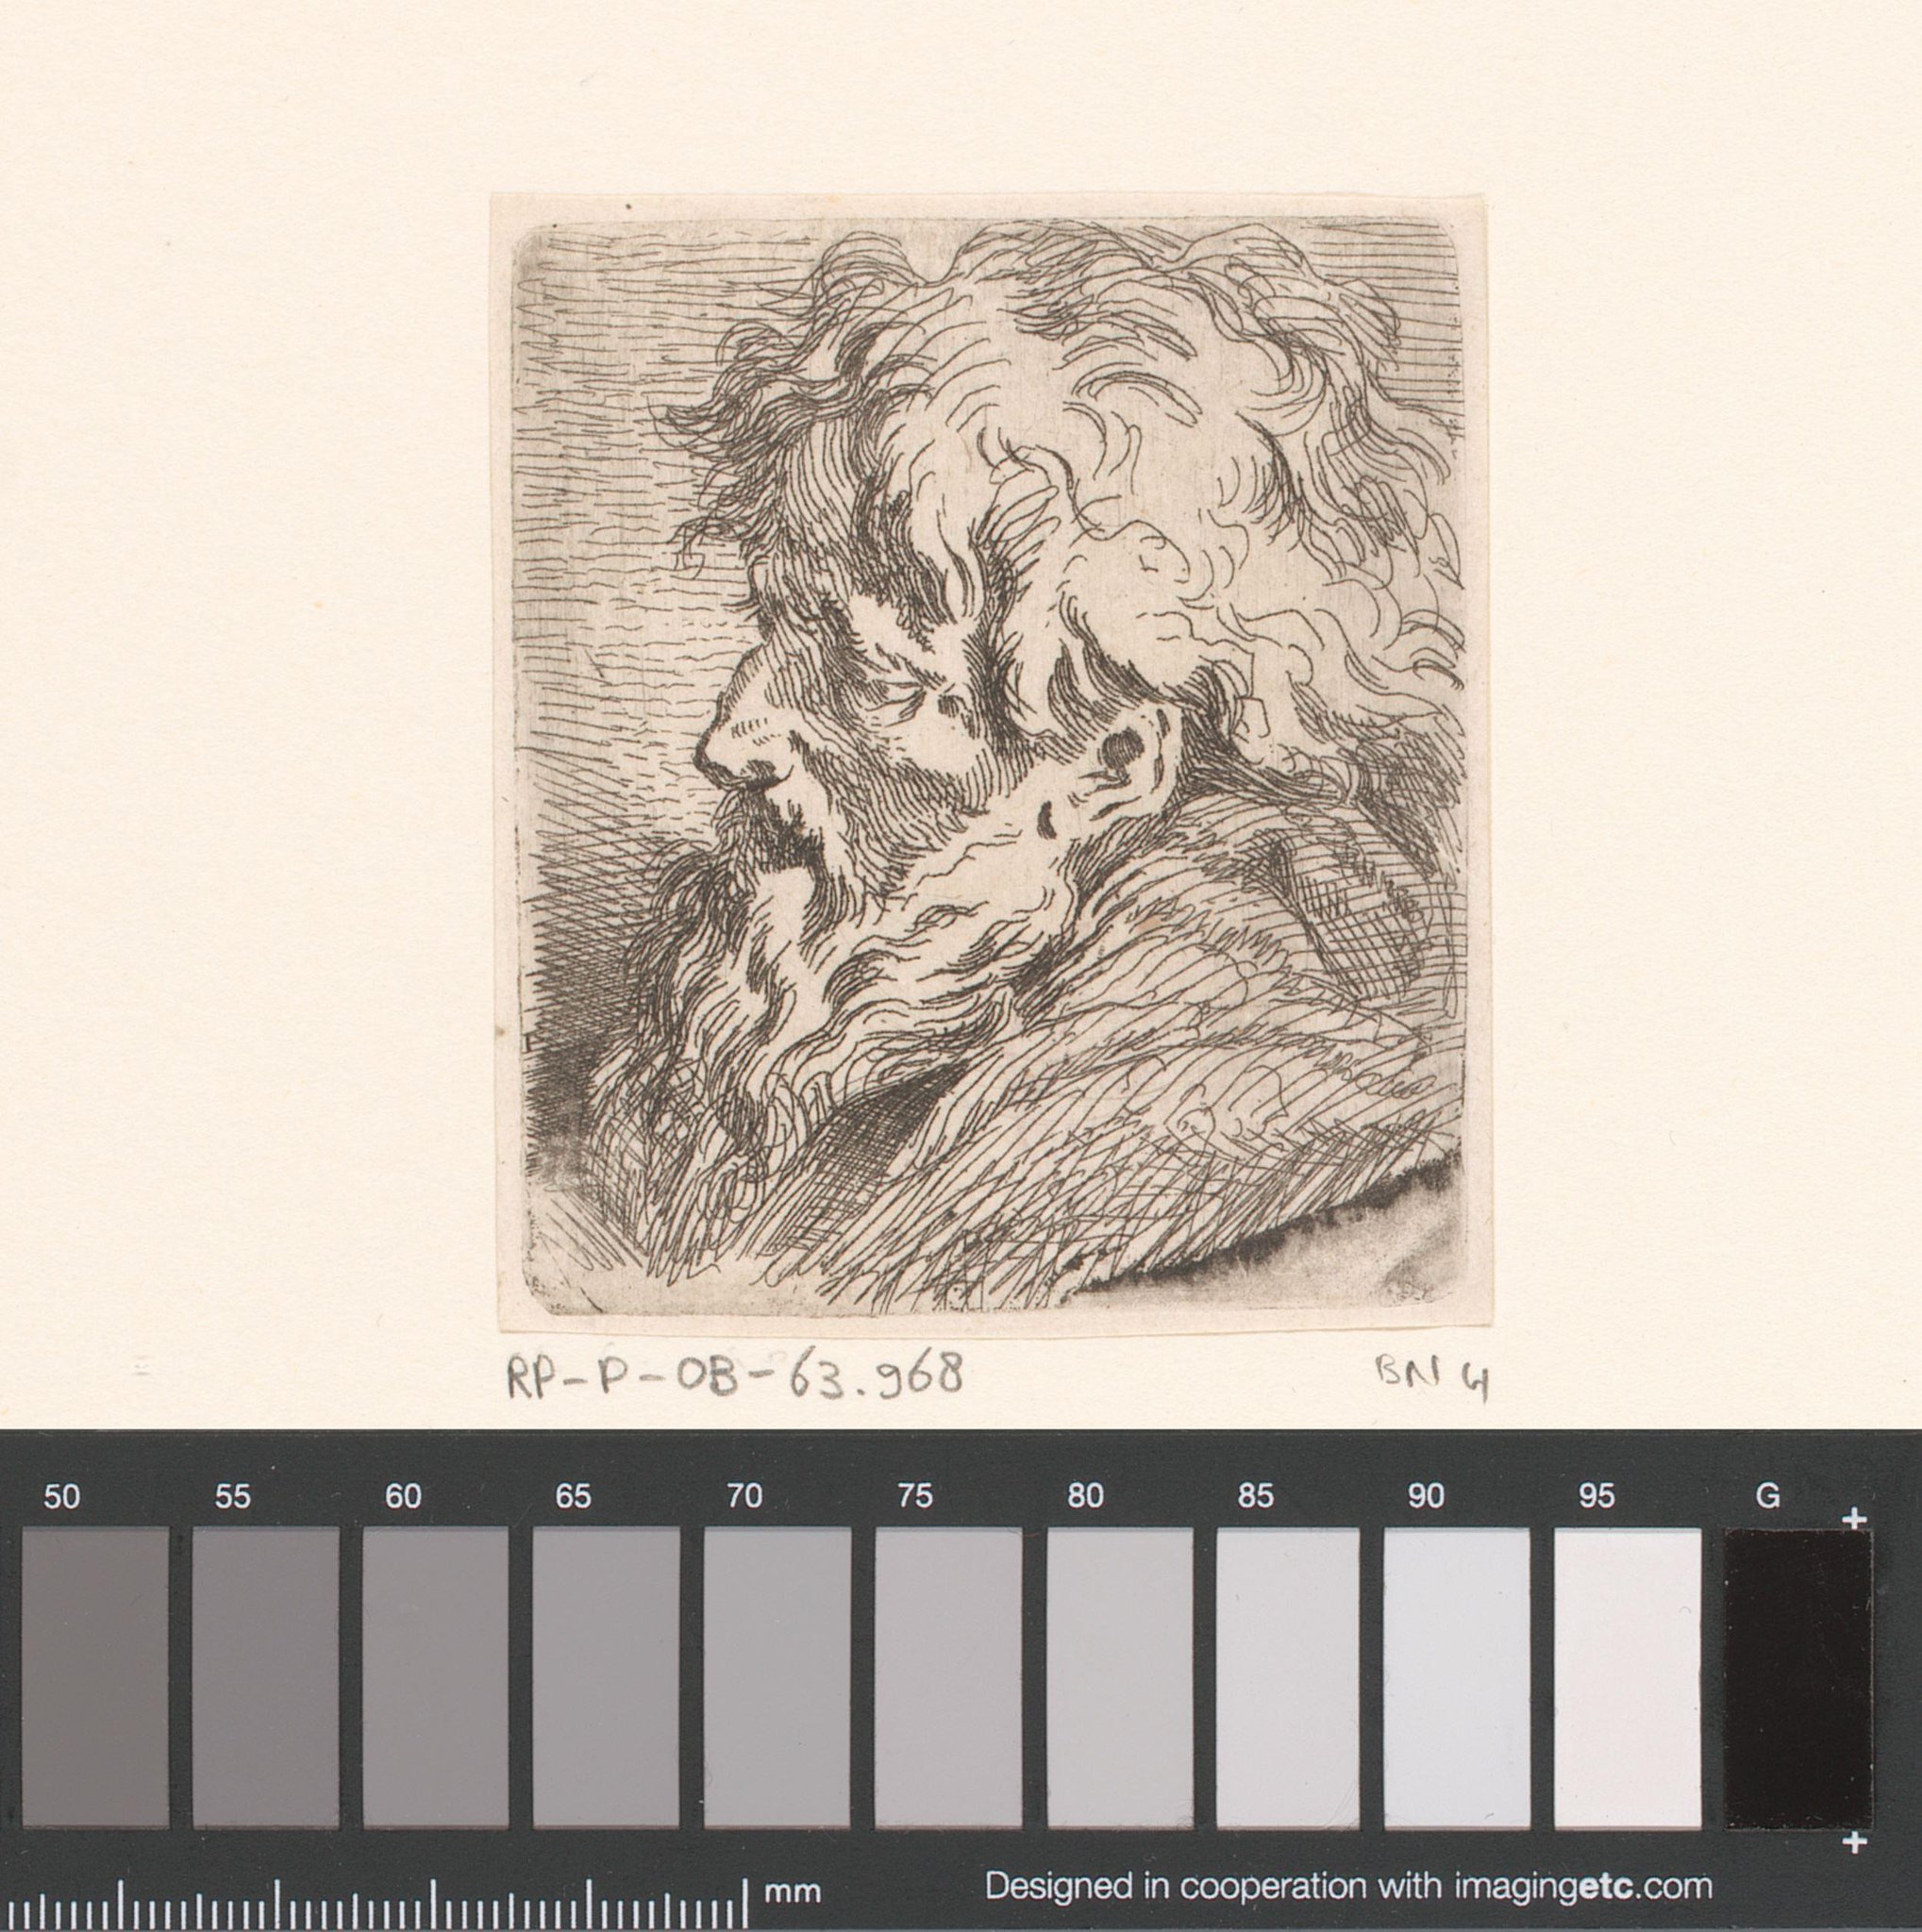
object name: print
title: Hoofd van een oudere man met baard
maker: jacques-philippe le bas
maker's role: draughtsman, print maker, publisher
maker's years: 1707-1783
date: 1736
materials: paper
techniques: etching, intaglio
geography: paris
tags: head (human), old man, beard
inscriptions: collector's mark: Lugt 240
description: Maakt deel uit van een twaalfdelige serie getiteld 'Recueil de divers griffonnemens et epreuves d'eau forte (...)', gegraveerd en uitgegeven door Le Bas te Parijs.